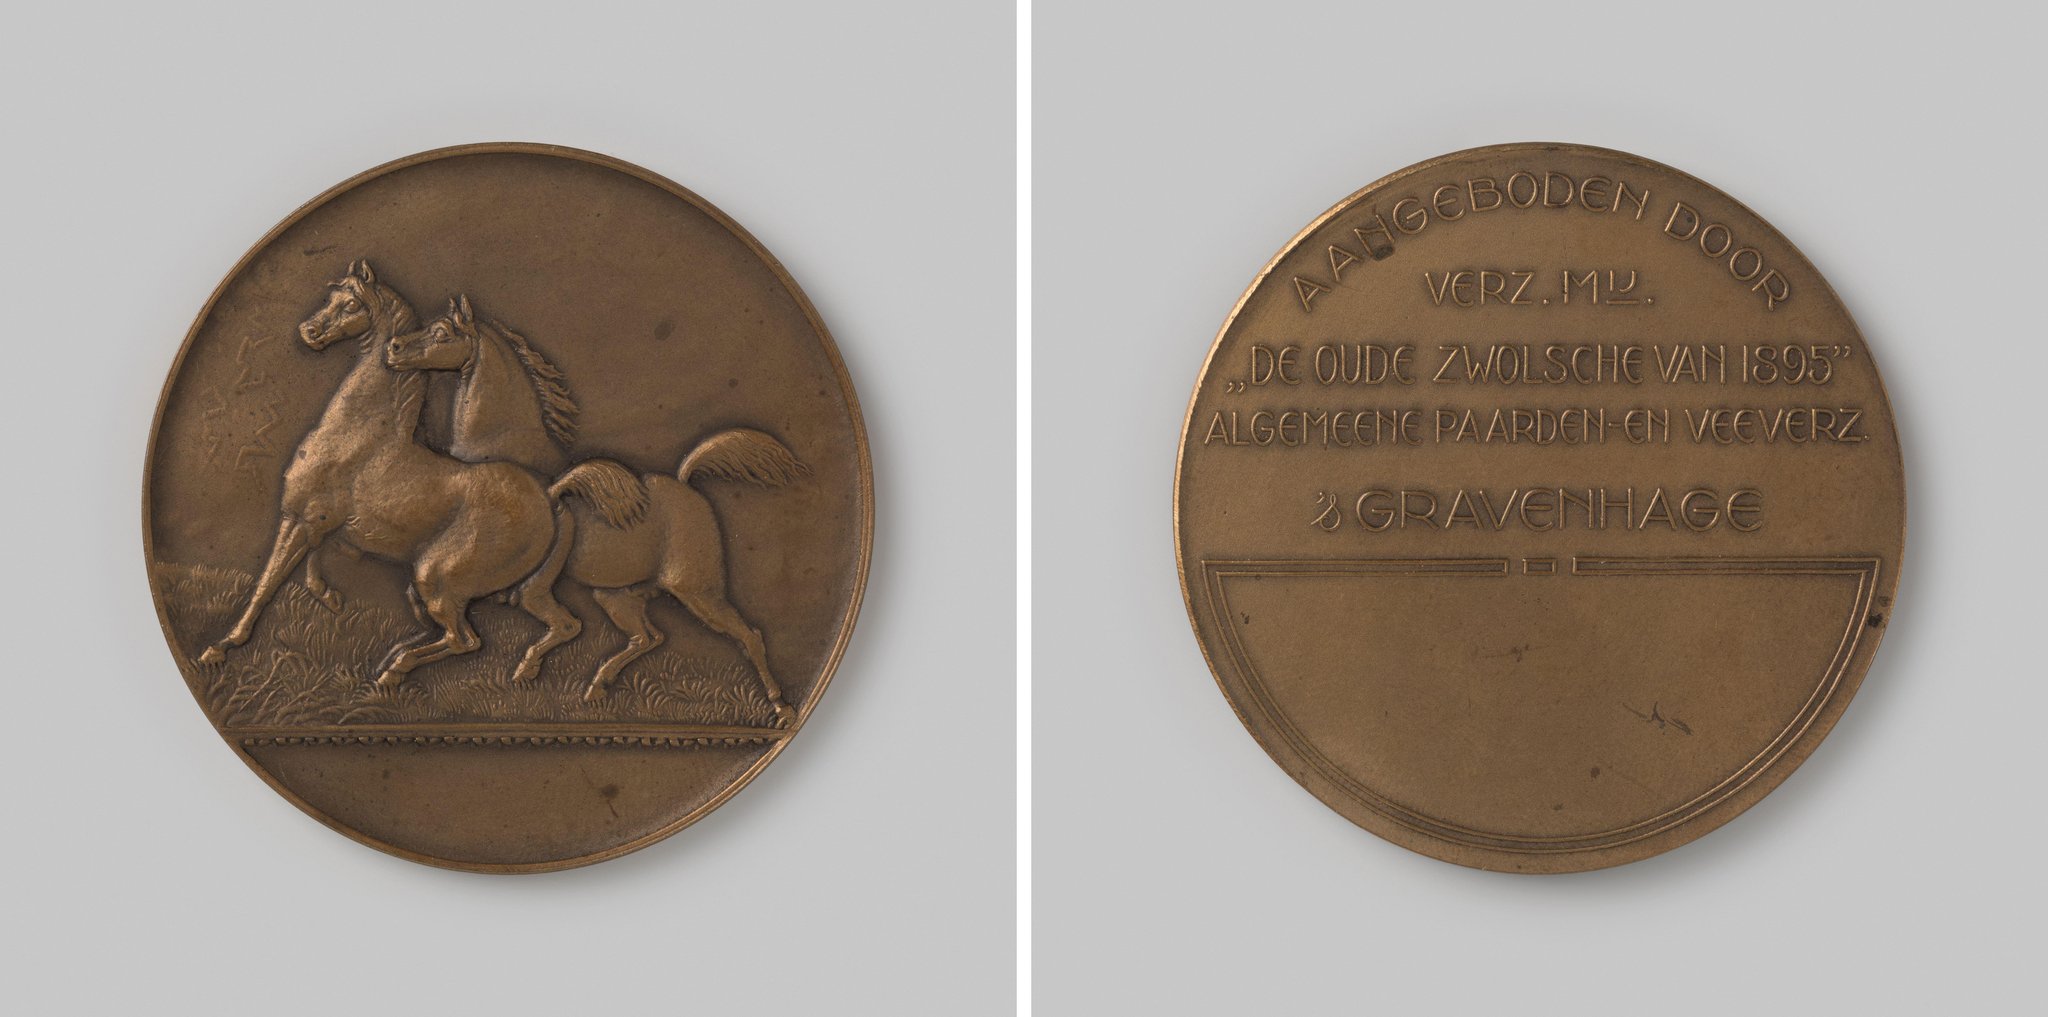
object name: history medal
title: Beloningspenning van de verzekeringsmaatschappij De Oude Zwolsche van 1895 te 's-Gravenhage (1922)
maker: eduard hüttl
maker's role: graveur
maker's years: 1893-1938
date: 1922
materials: bronze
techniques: striking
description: Bronzen penning, op de voorzijde twee paarden nar links in grasland, op de keerzijde vijf regels tekst boven een halvecirkelvormige inscriptieruimte.